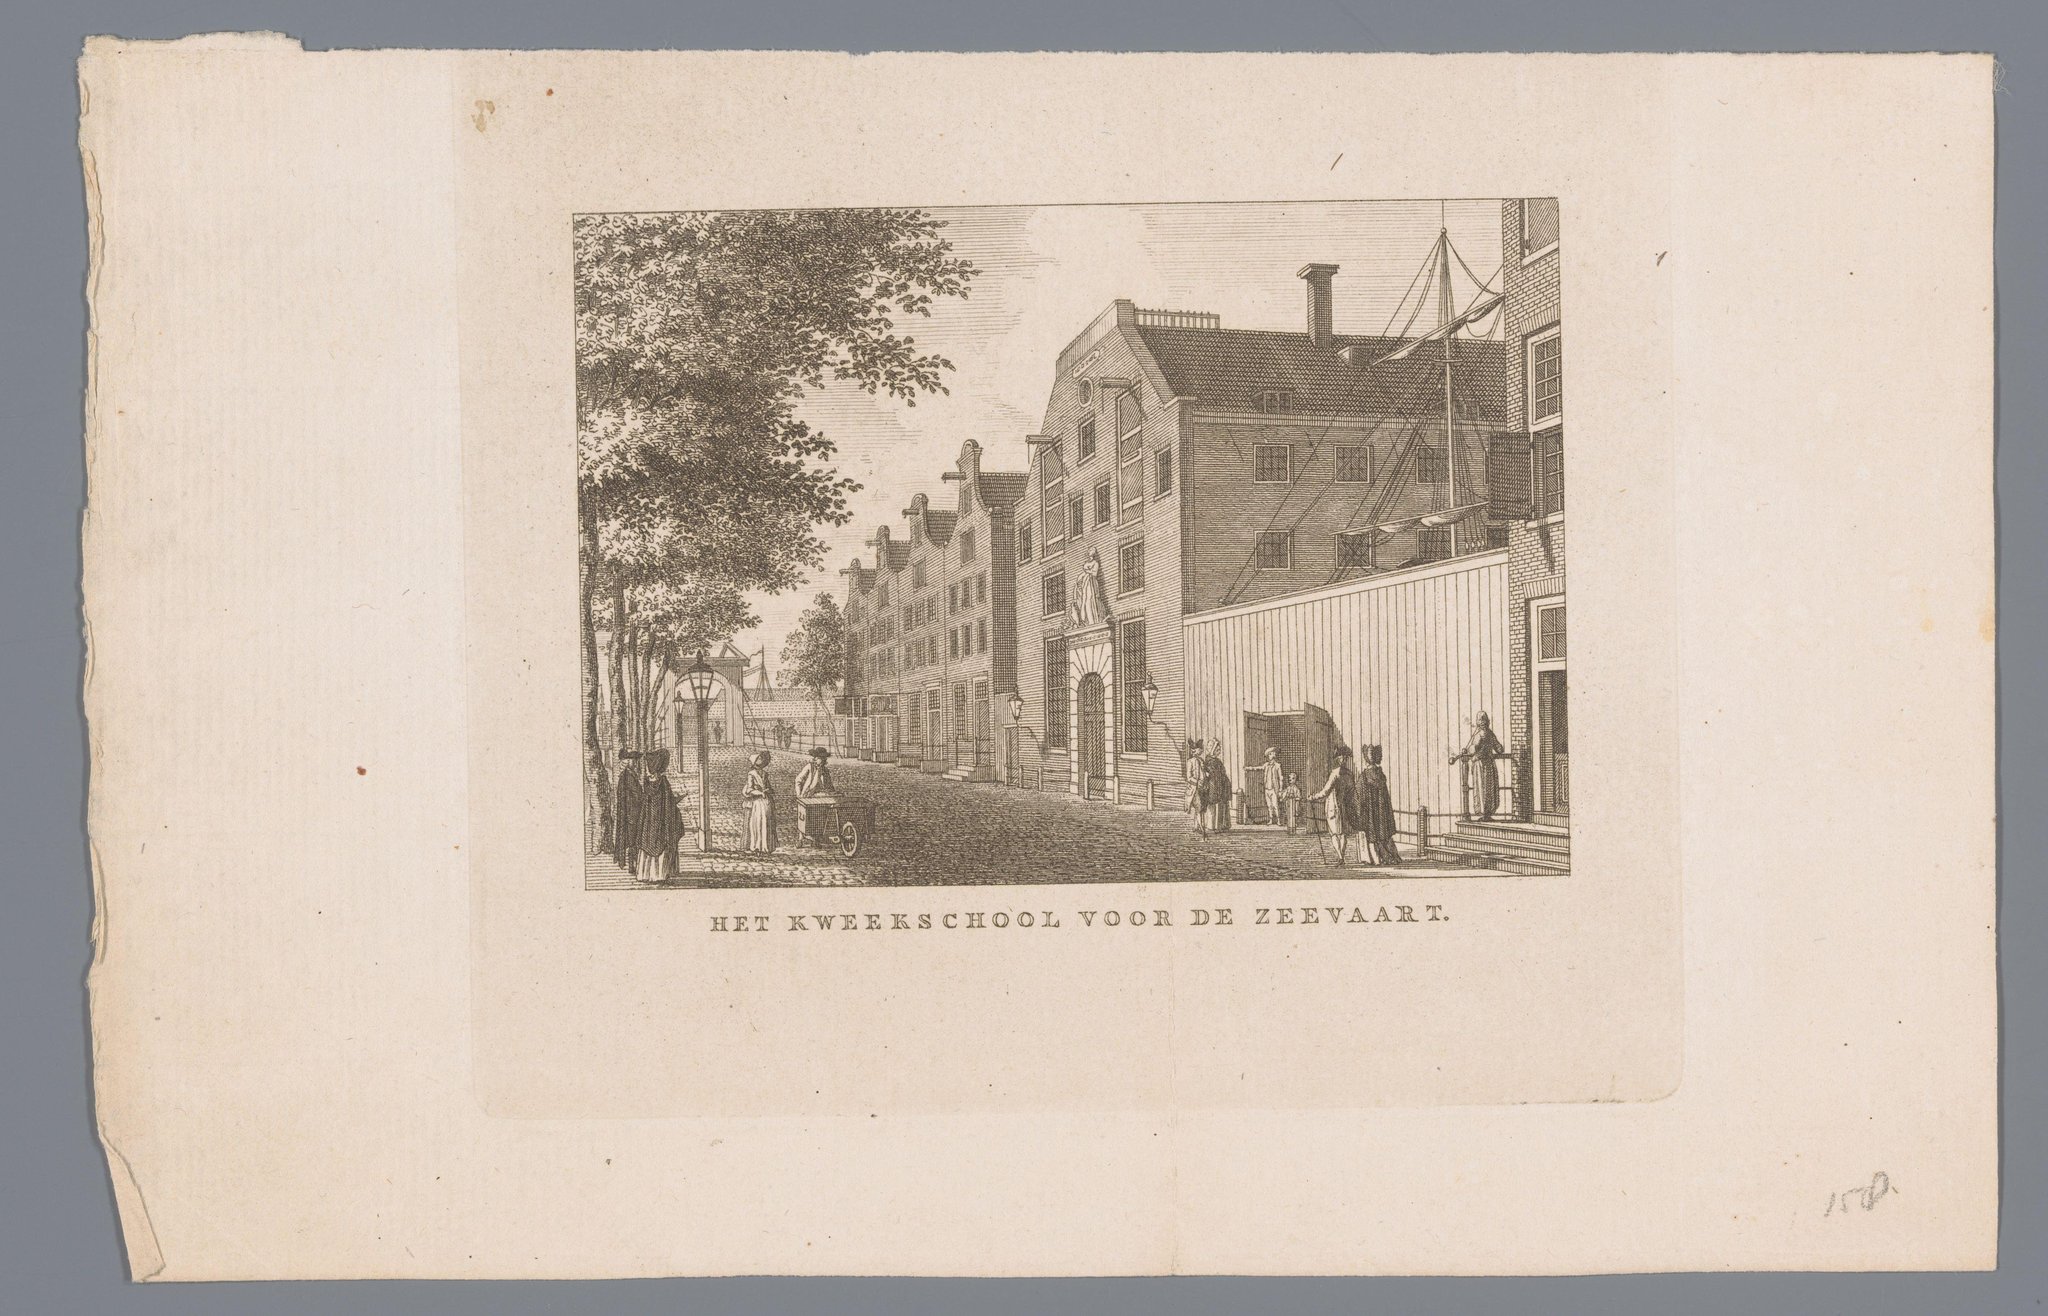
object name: print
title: Het Kweekschool voor de Zeevaart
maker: Anonymous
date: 1790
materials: paper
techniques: etching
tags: civic architecture; edifices; dwellings, amsterdam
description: Onderste deel van een prent met meerdere stadsgezichten van Amsterdam.